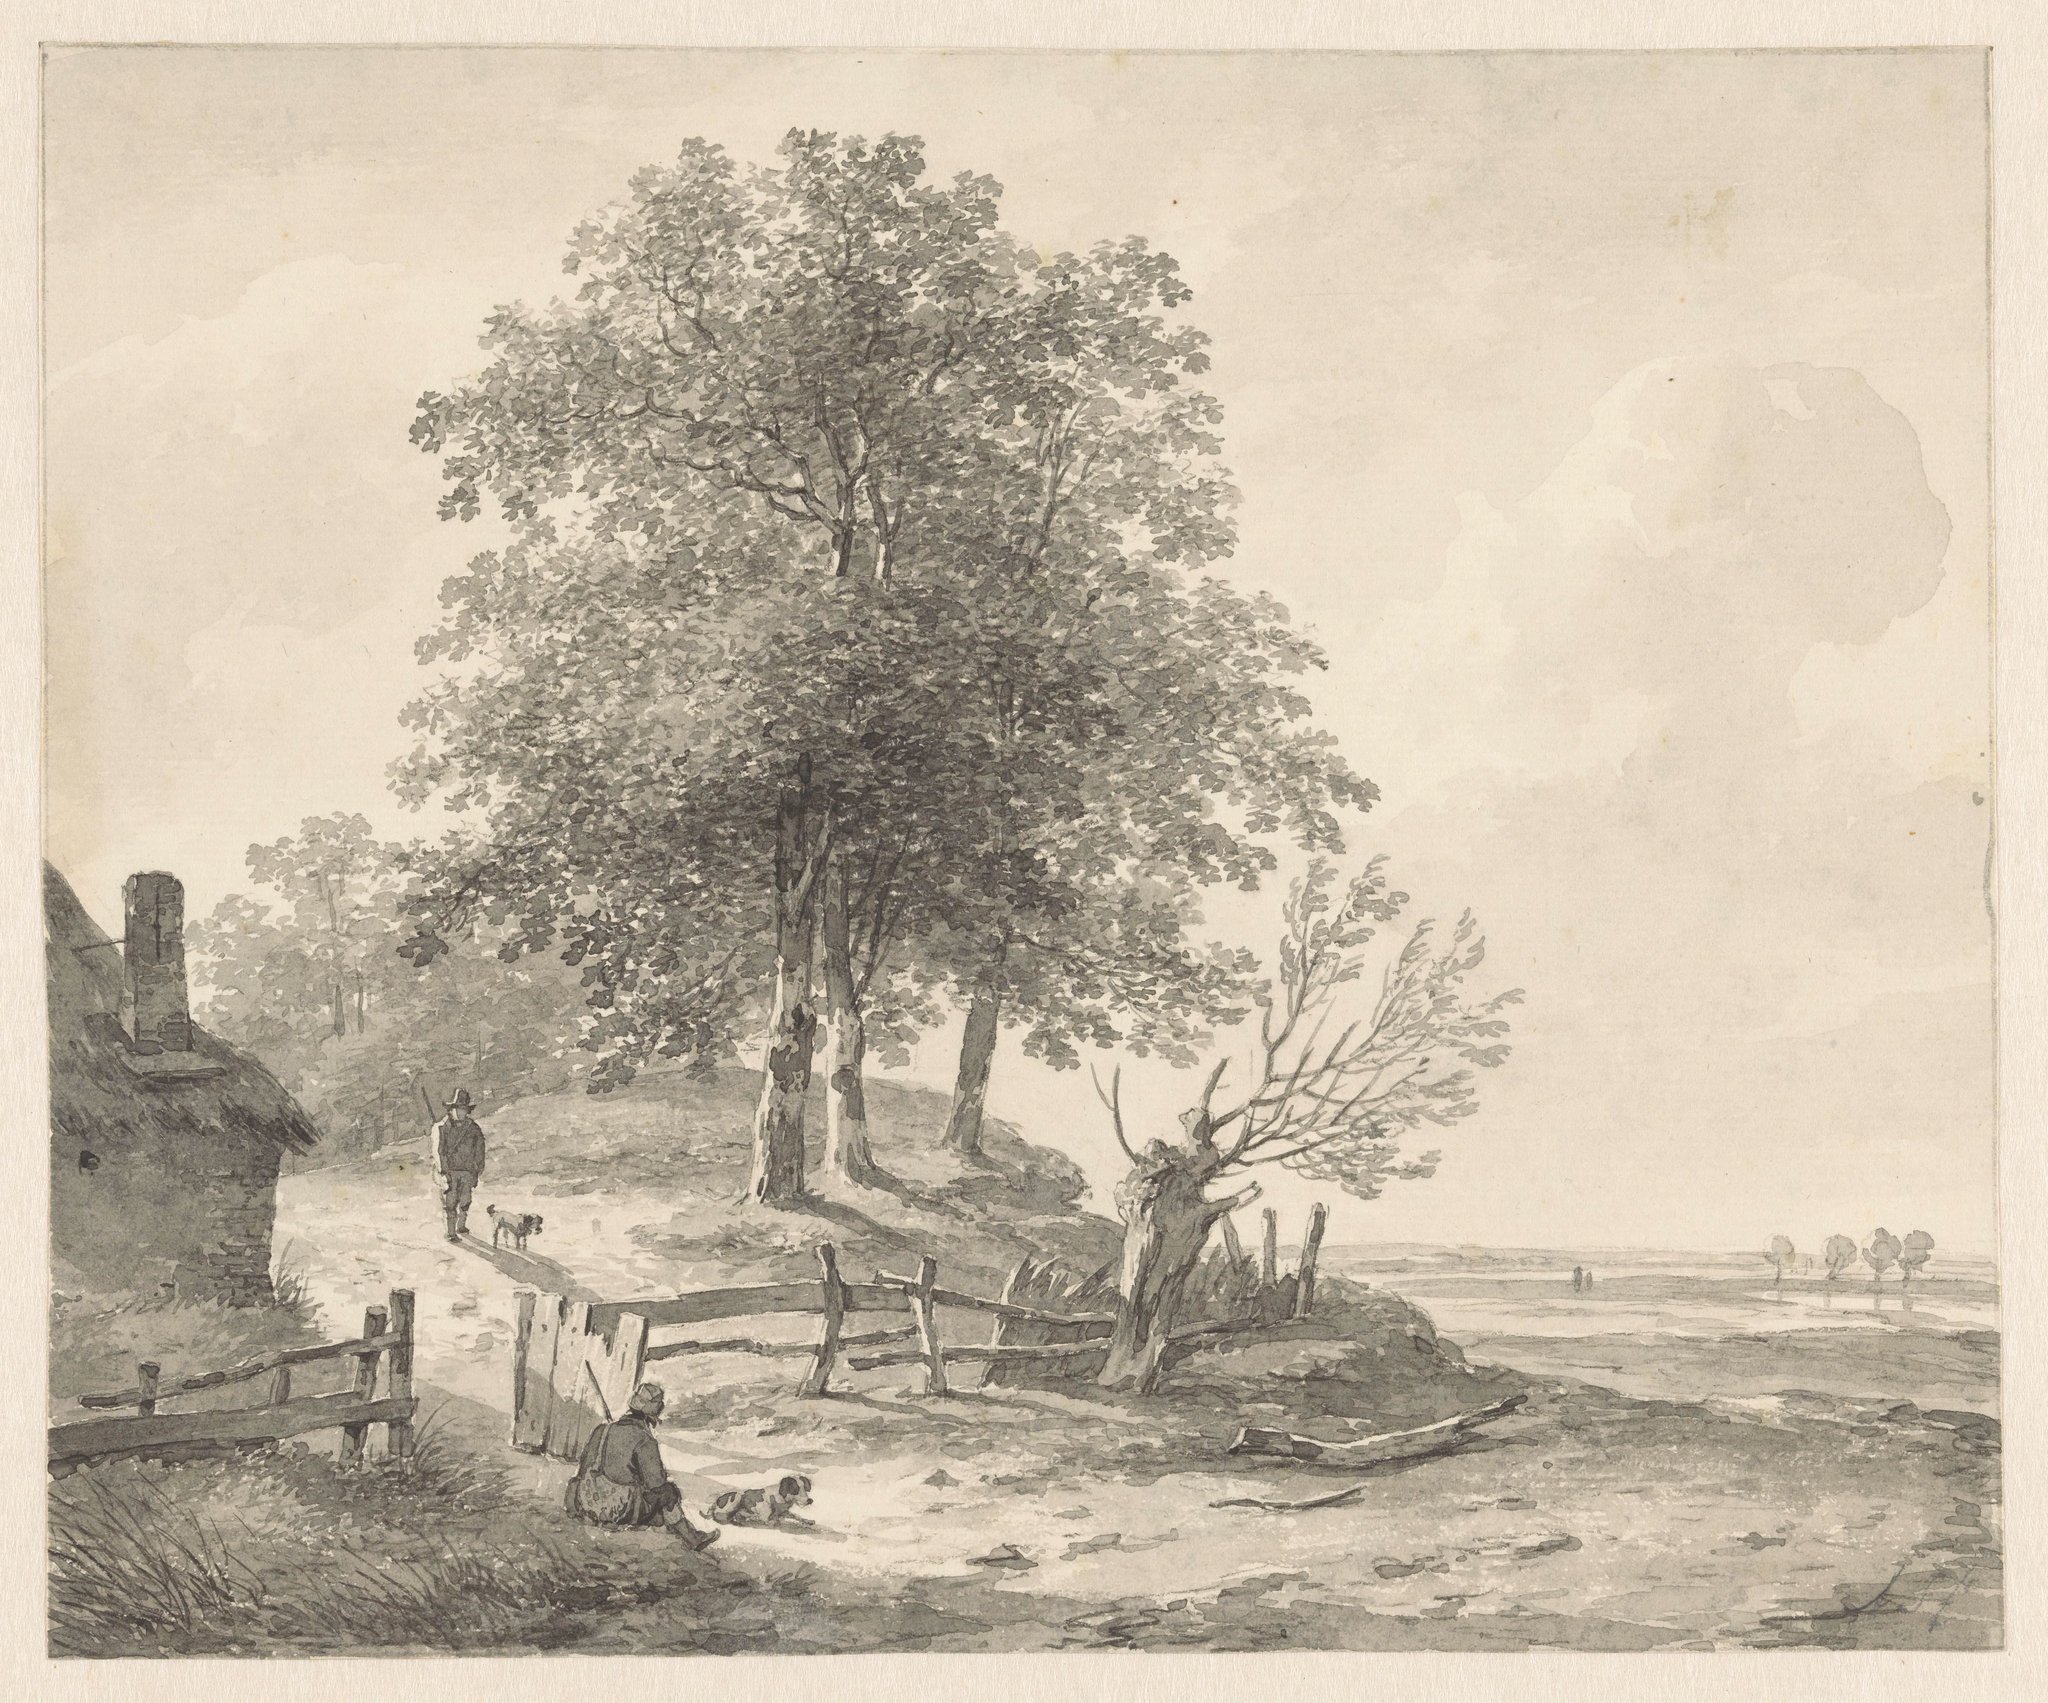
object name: drawing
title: Landschap met een huisje op een heuvel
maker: andreas schelfhout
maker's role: draughtsman, painter, print maker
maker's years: 1787-1870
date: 1797-1870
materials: chalk, paper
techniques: brush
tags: hunter, farm or solitary house in landscape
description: Landschap met links een heuvel met daarop een huisje en enkele bomen en twee jagers met hond.